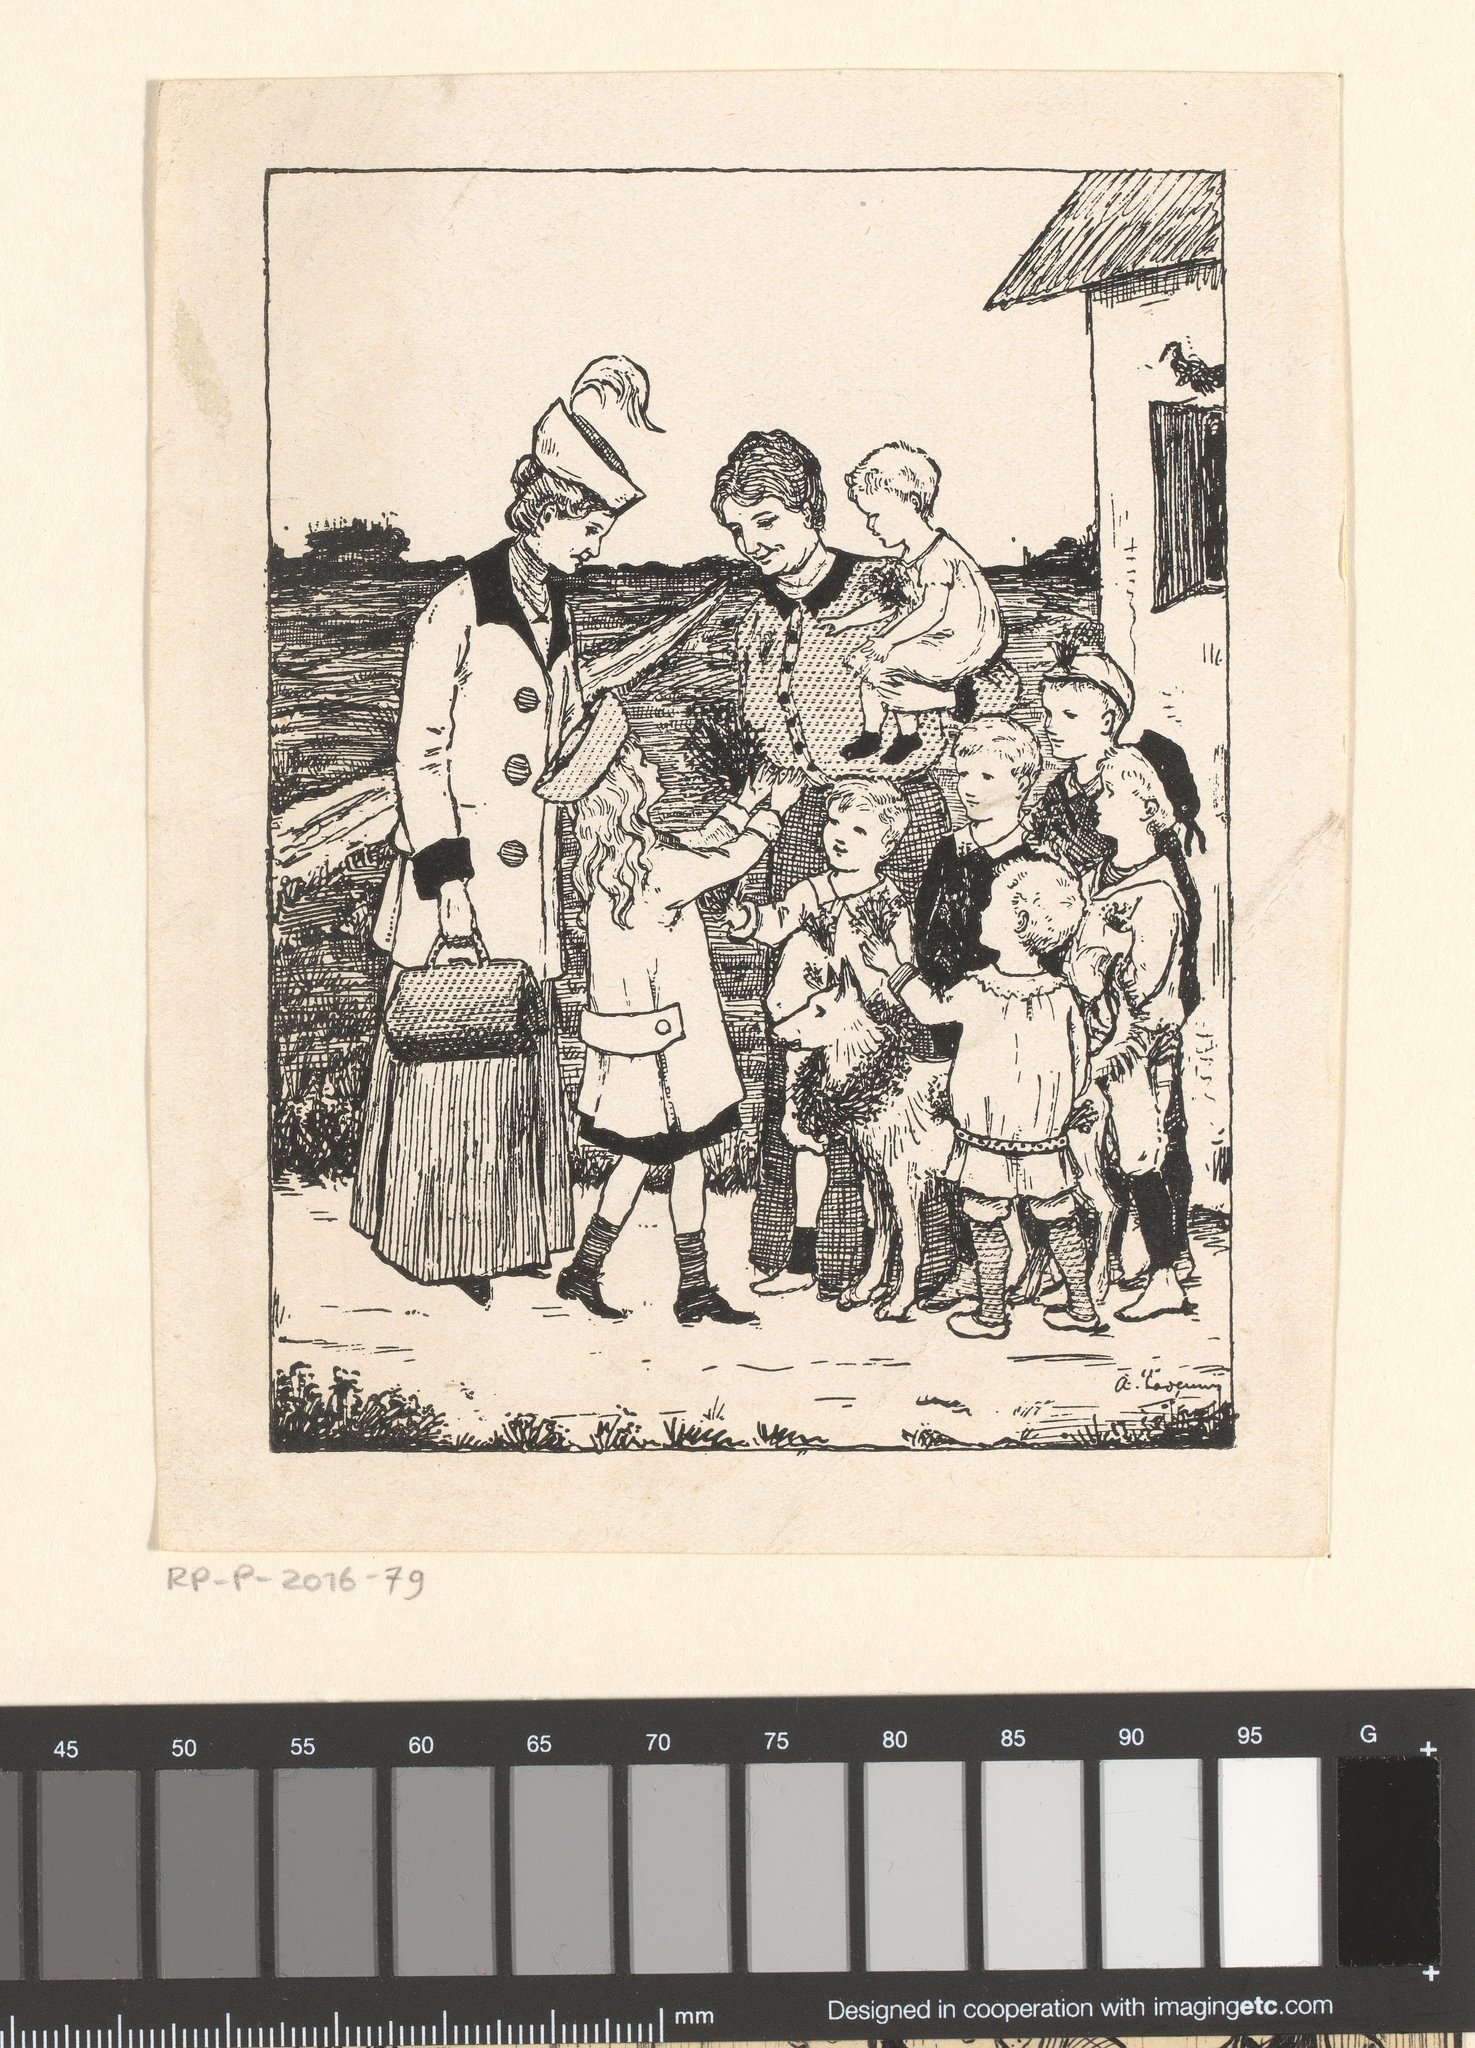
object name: photomechanical print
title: Kinderen bieden een vrouw heidebloemen aan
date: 1910-1940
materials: paper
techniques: printing block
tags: cut flowers; nosegay, bunch of flowers, child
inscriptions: collector's mark: Lugt 2228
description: Bij een plattelandswoning staat een vrouw met een kind op de arm. Ze wordt omringd door een groep kinderen met bosjes bloemen in de handen en op de kleding. Eén meisje biedt de vrouw bloemen aan.